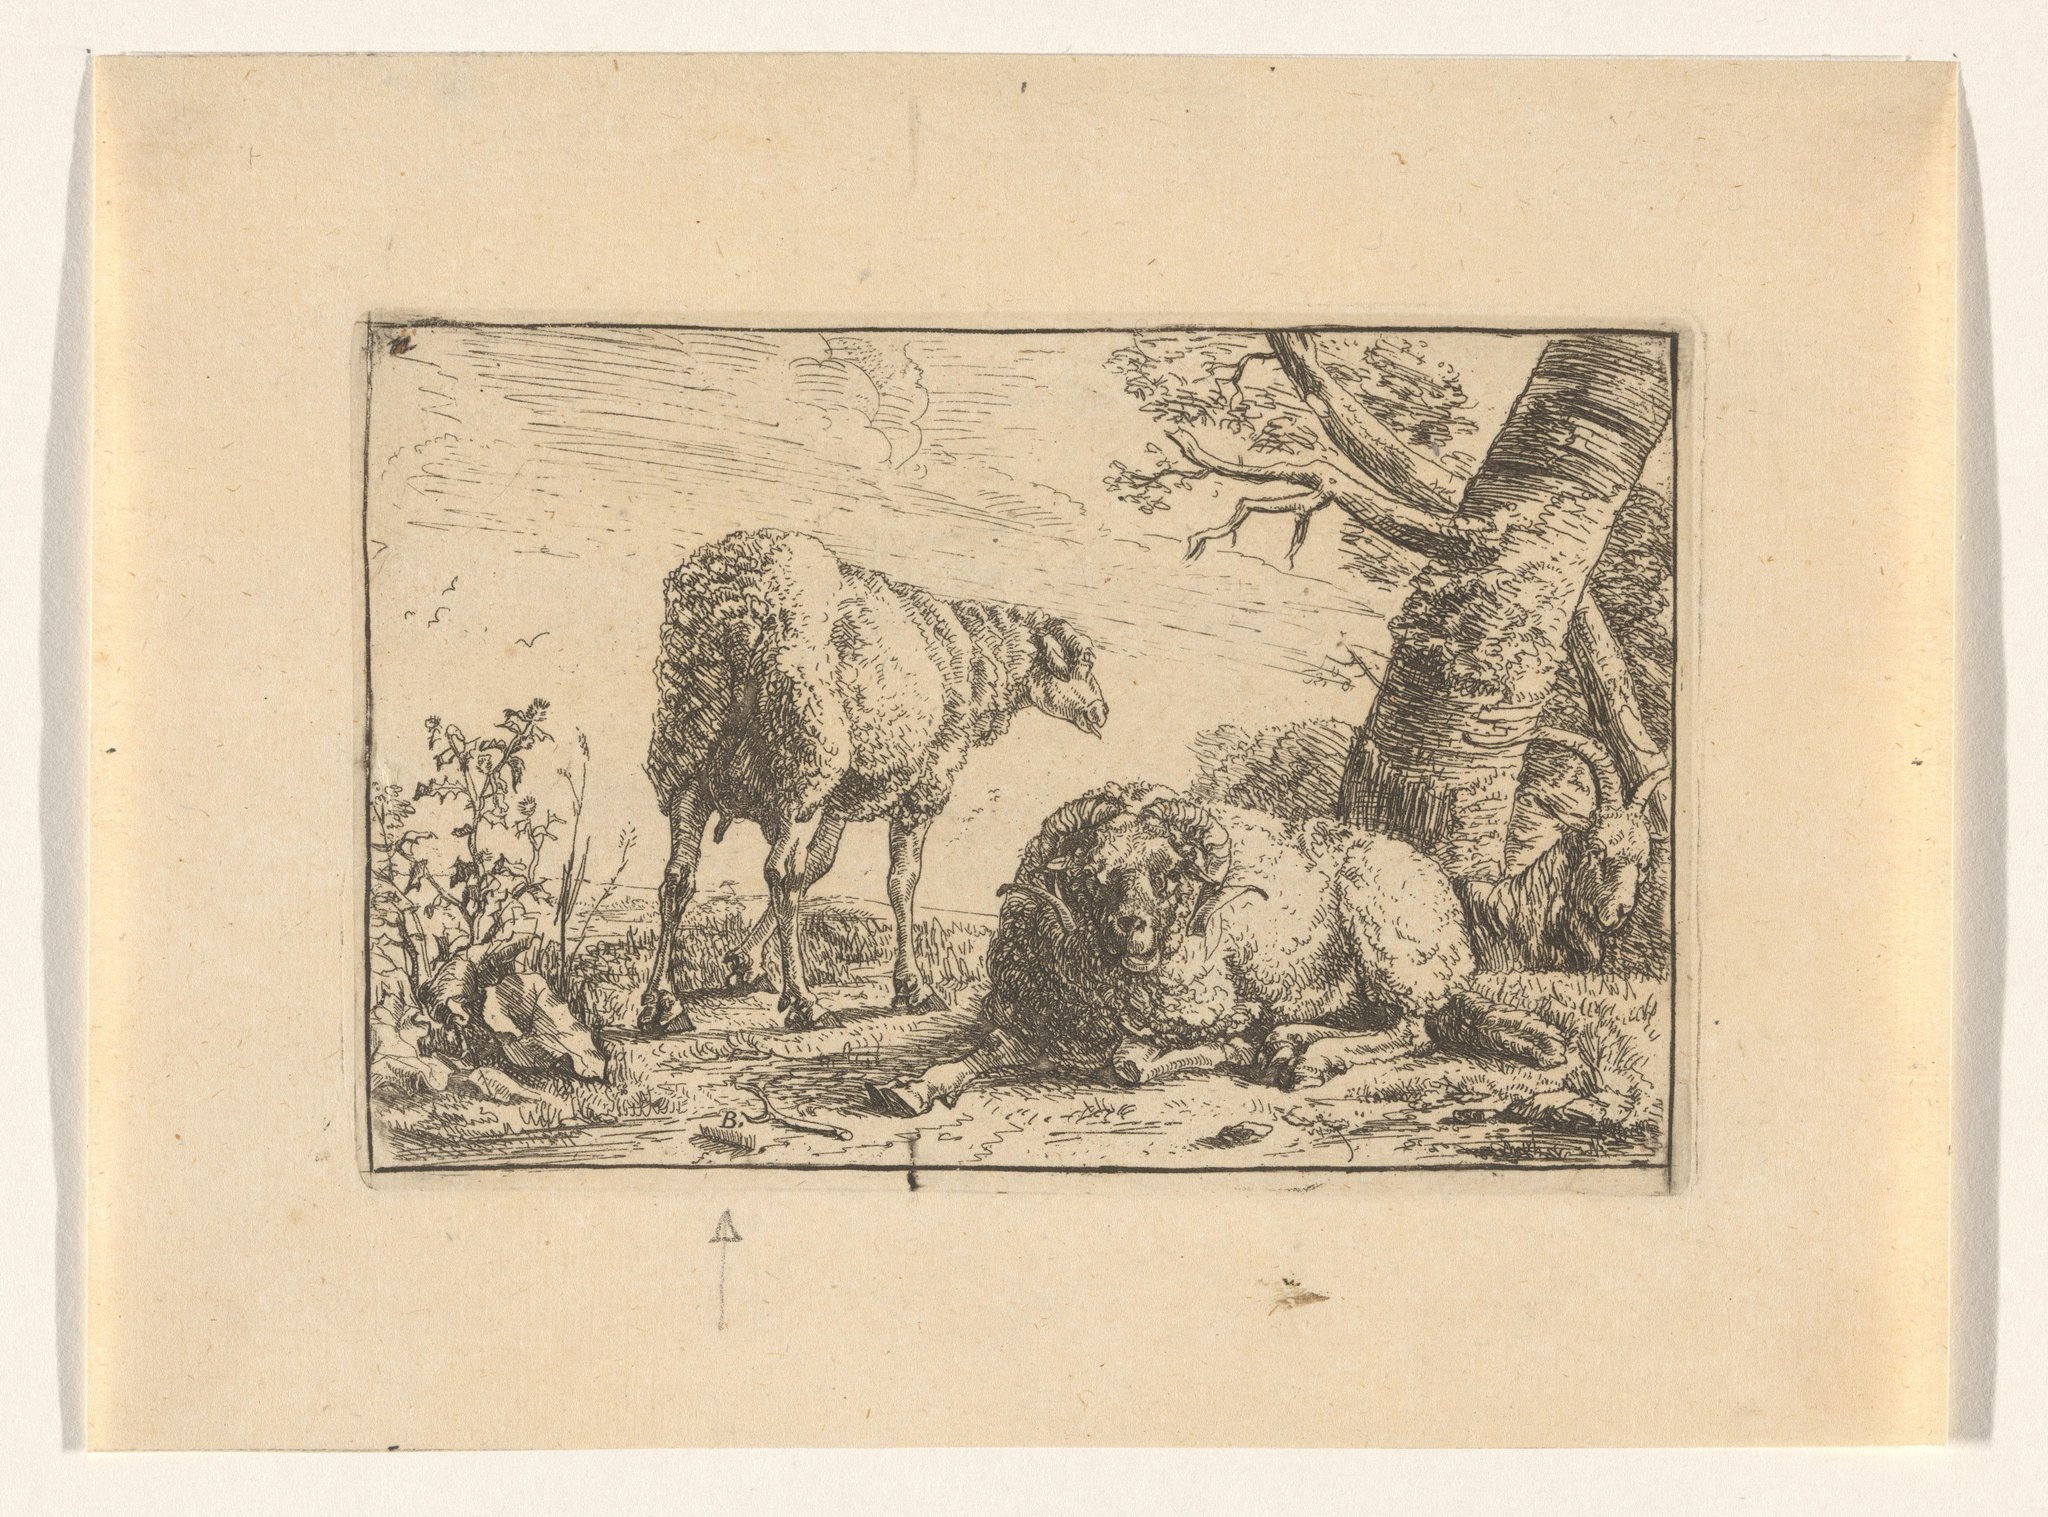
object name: print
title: Twee schapen en een geit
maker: barend graat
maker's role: draughtsman, print maker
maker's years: 1628-1709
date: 1638-1652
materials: paper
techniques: etching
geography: amsterdam